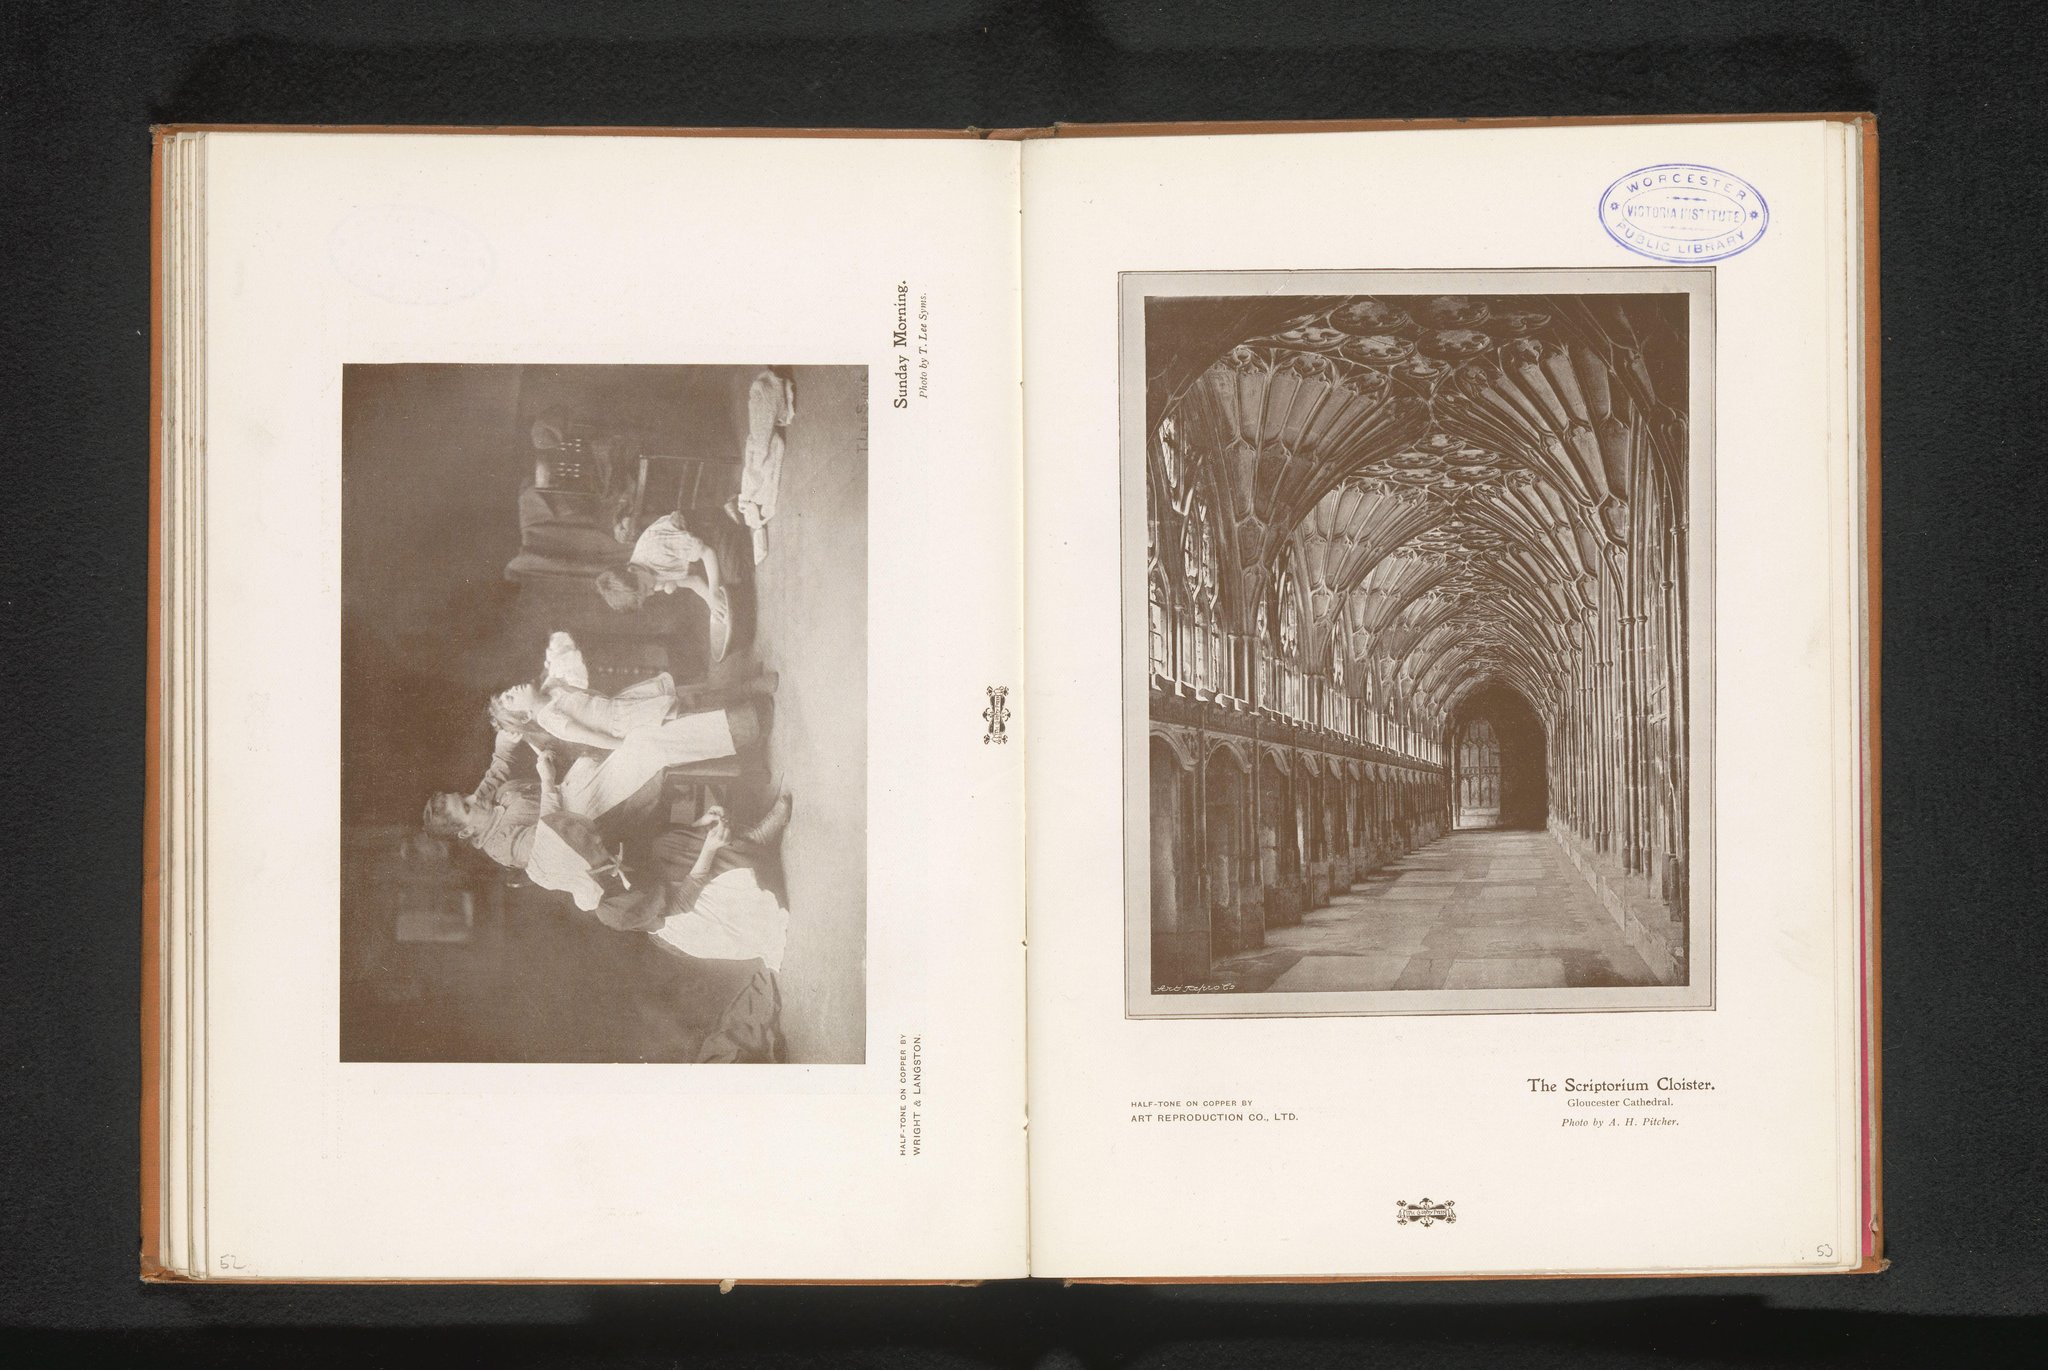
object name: page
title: Zondagmorgen in huis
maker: t. lee syms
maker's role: fotograaf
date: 1894-1899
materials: paper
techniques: autotype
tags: washing and bathing, interior of the house, dressing oneself, getting dressed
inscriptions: collector's mark: ‘Worcester Public Library/ Victoria Institute’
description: Prent op vierde ongenummerde pagina na pagina 72.